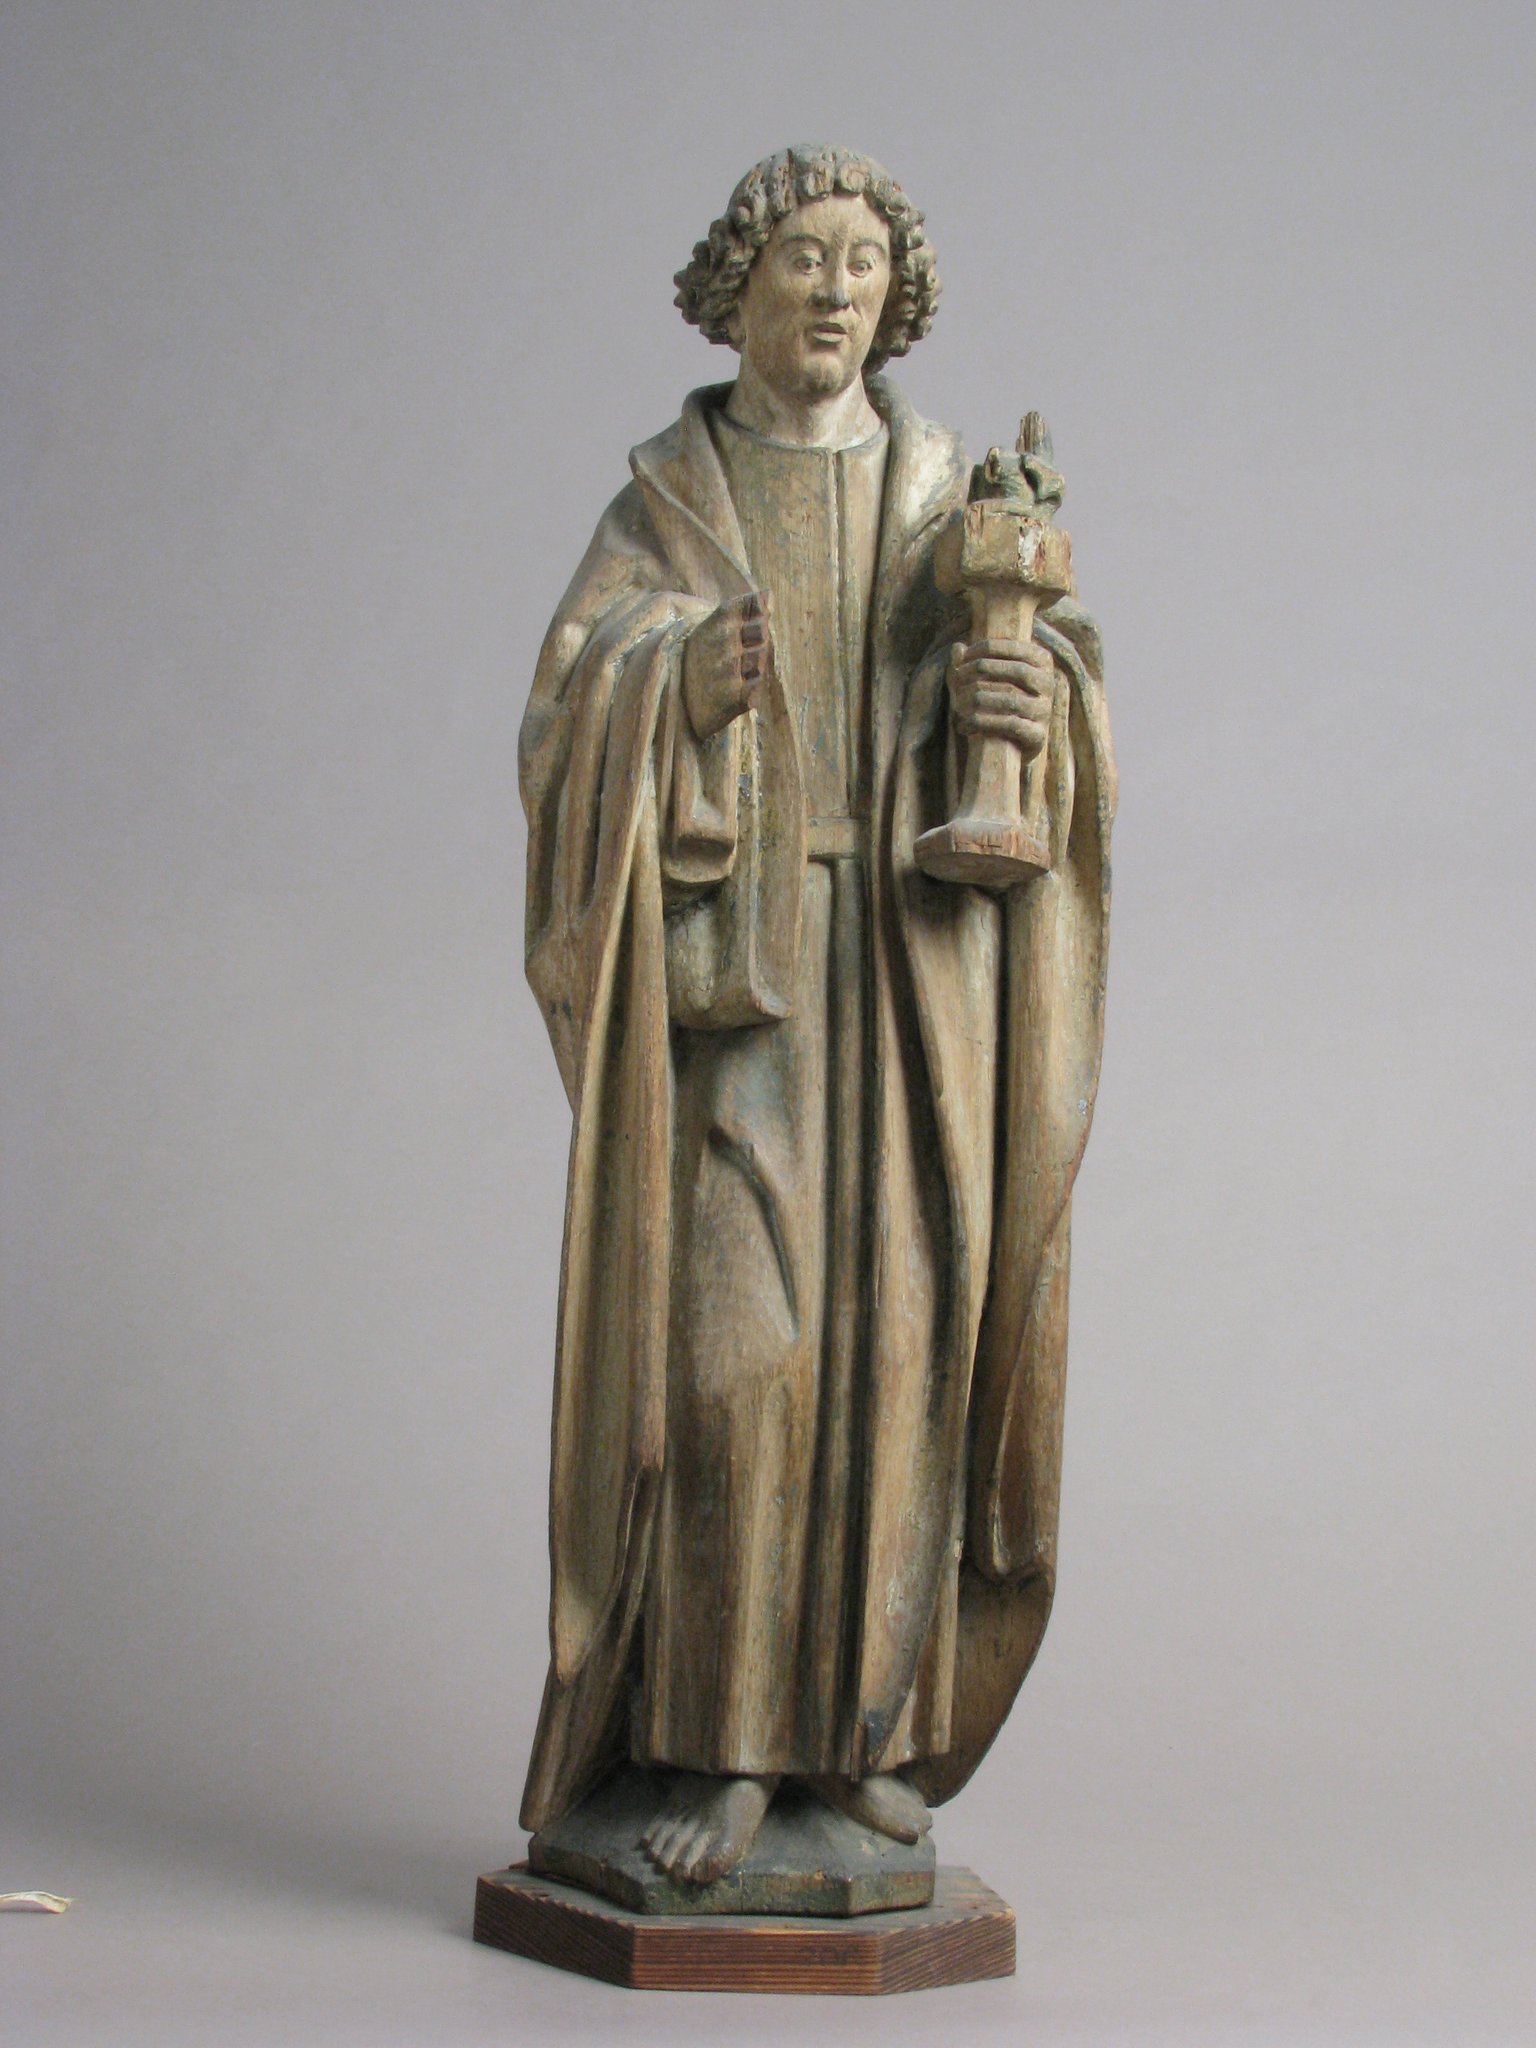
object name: statuette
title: Saint John, Apostle and Evangelist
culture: dutch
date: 1500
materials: wood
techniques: gilding, polychromy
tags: apostles